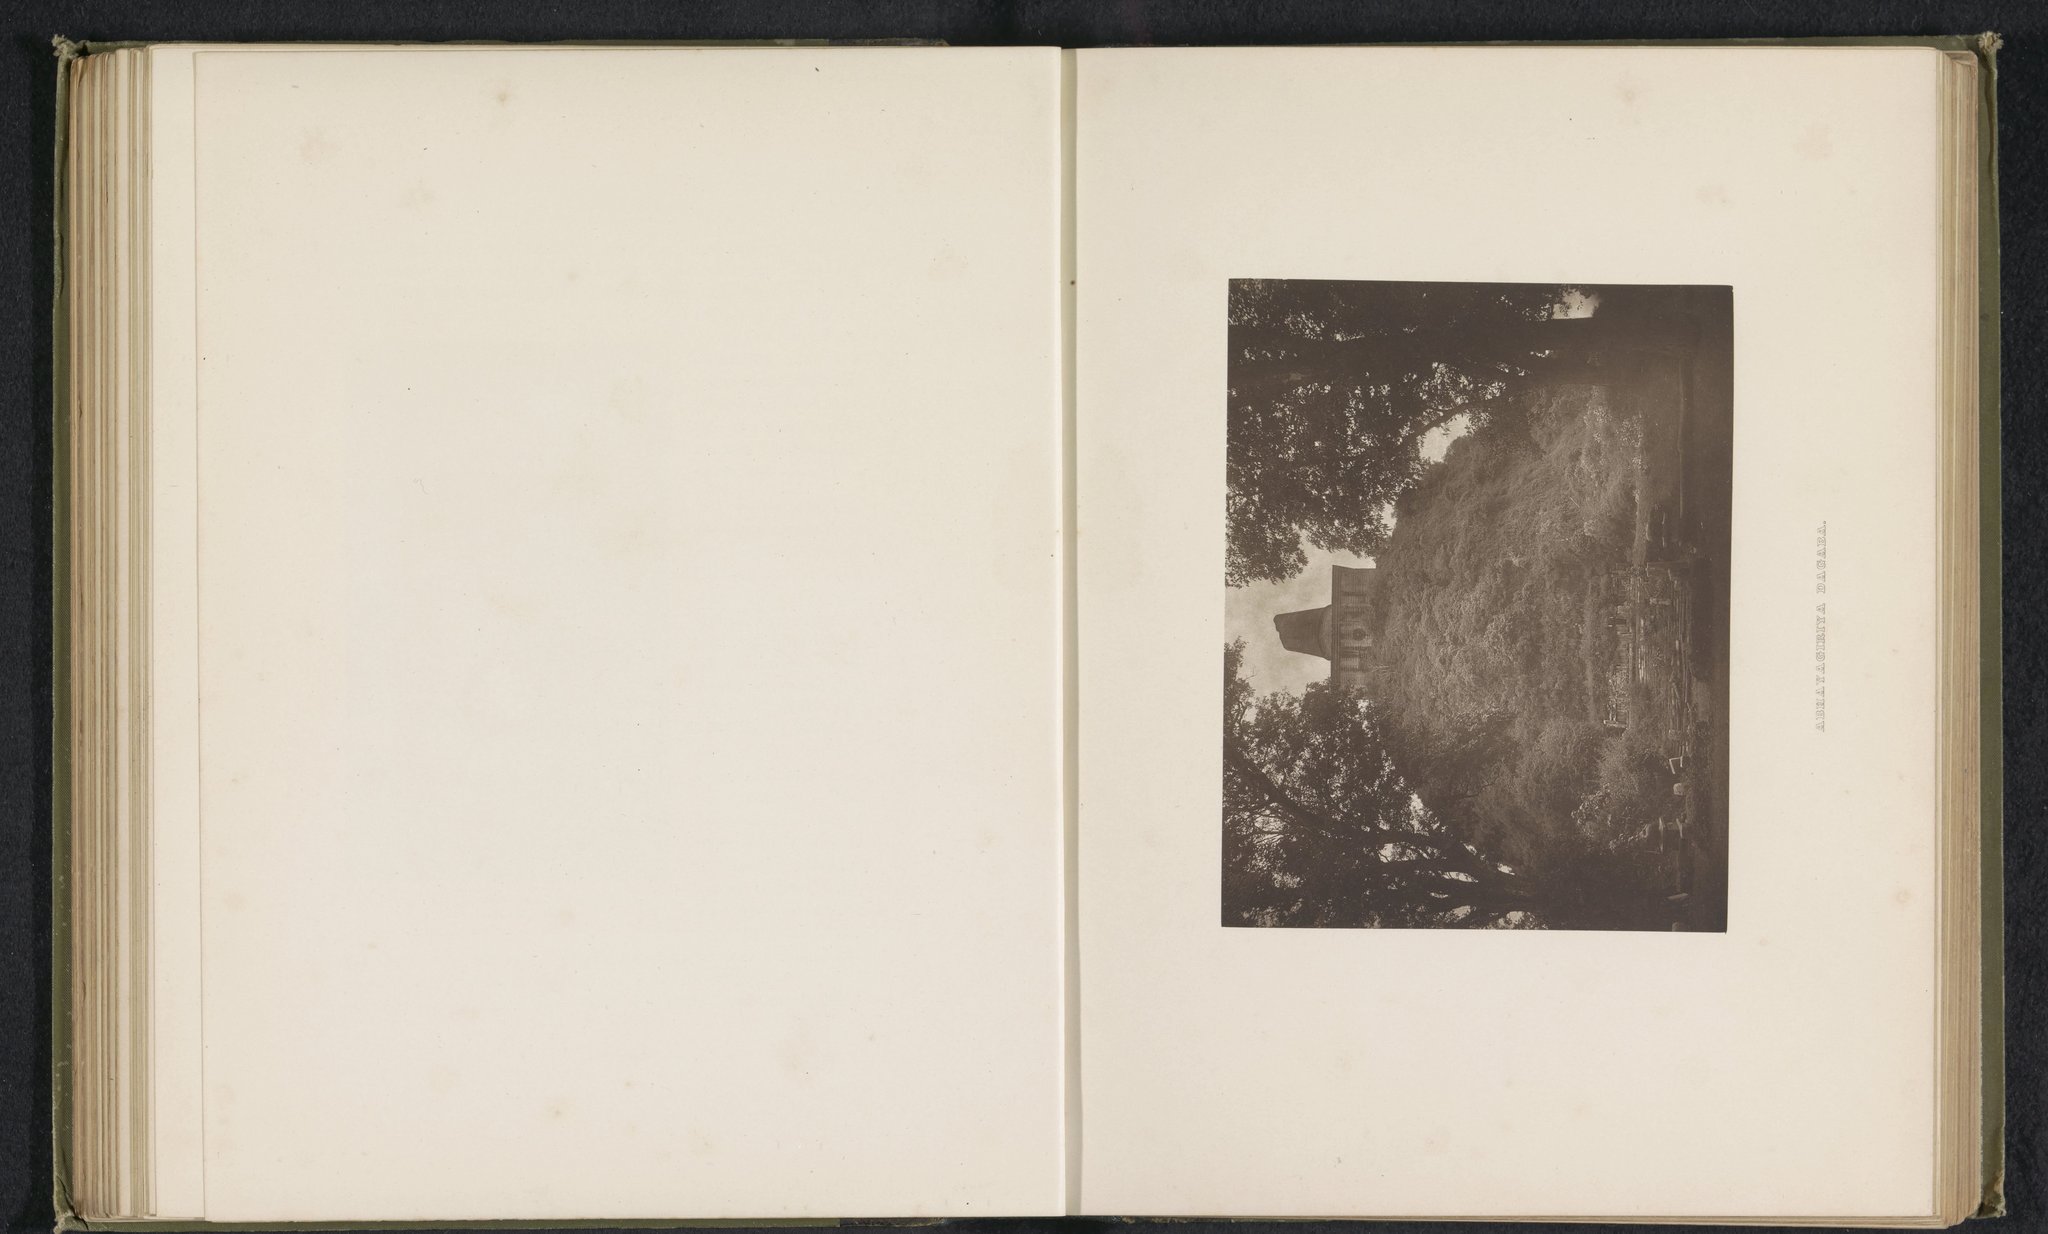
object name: photomechanical print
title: View of the stupa of the Abhayagiri vihāra monastic complex in Anuradhapura, Sri Lanka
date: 1896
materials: paper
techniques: woodburygravure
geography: anuradhapura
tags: temple, shrine ~ hinduism, buddhism, jainism, ruin of a building ~ architecture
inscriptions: title: ‘ABHAYAGIRIYA DAGABA.’